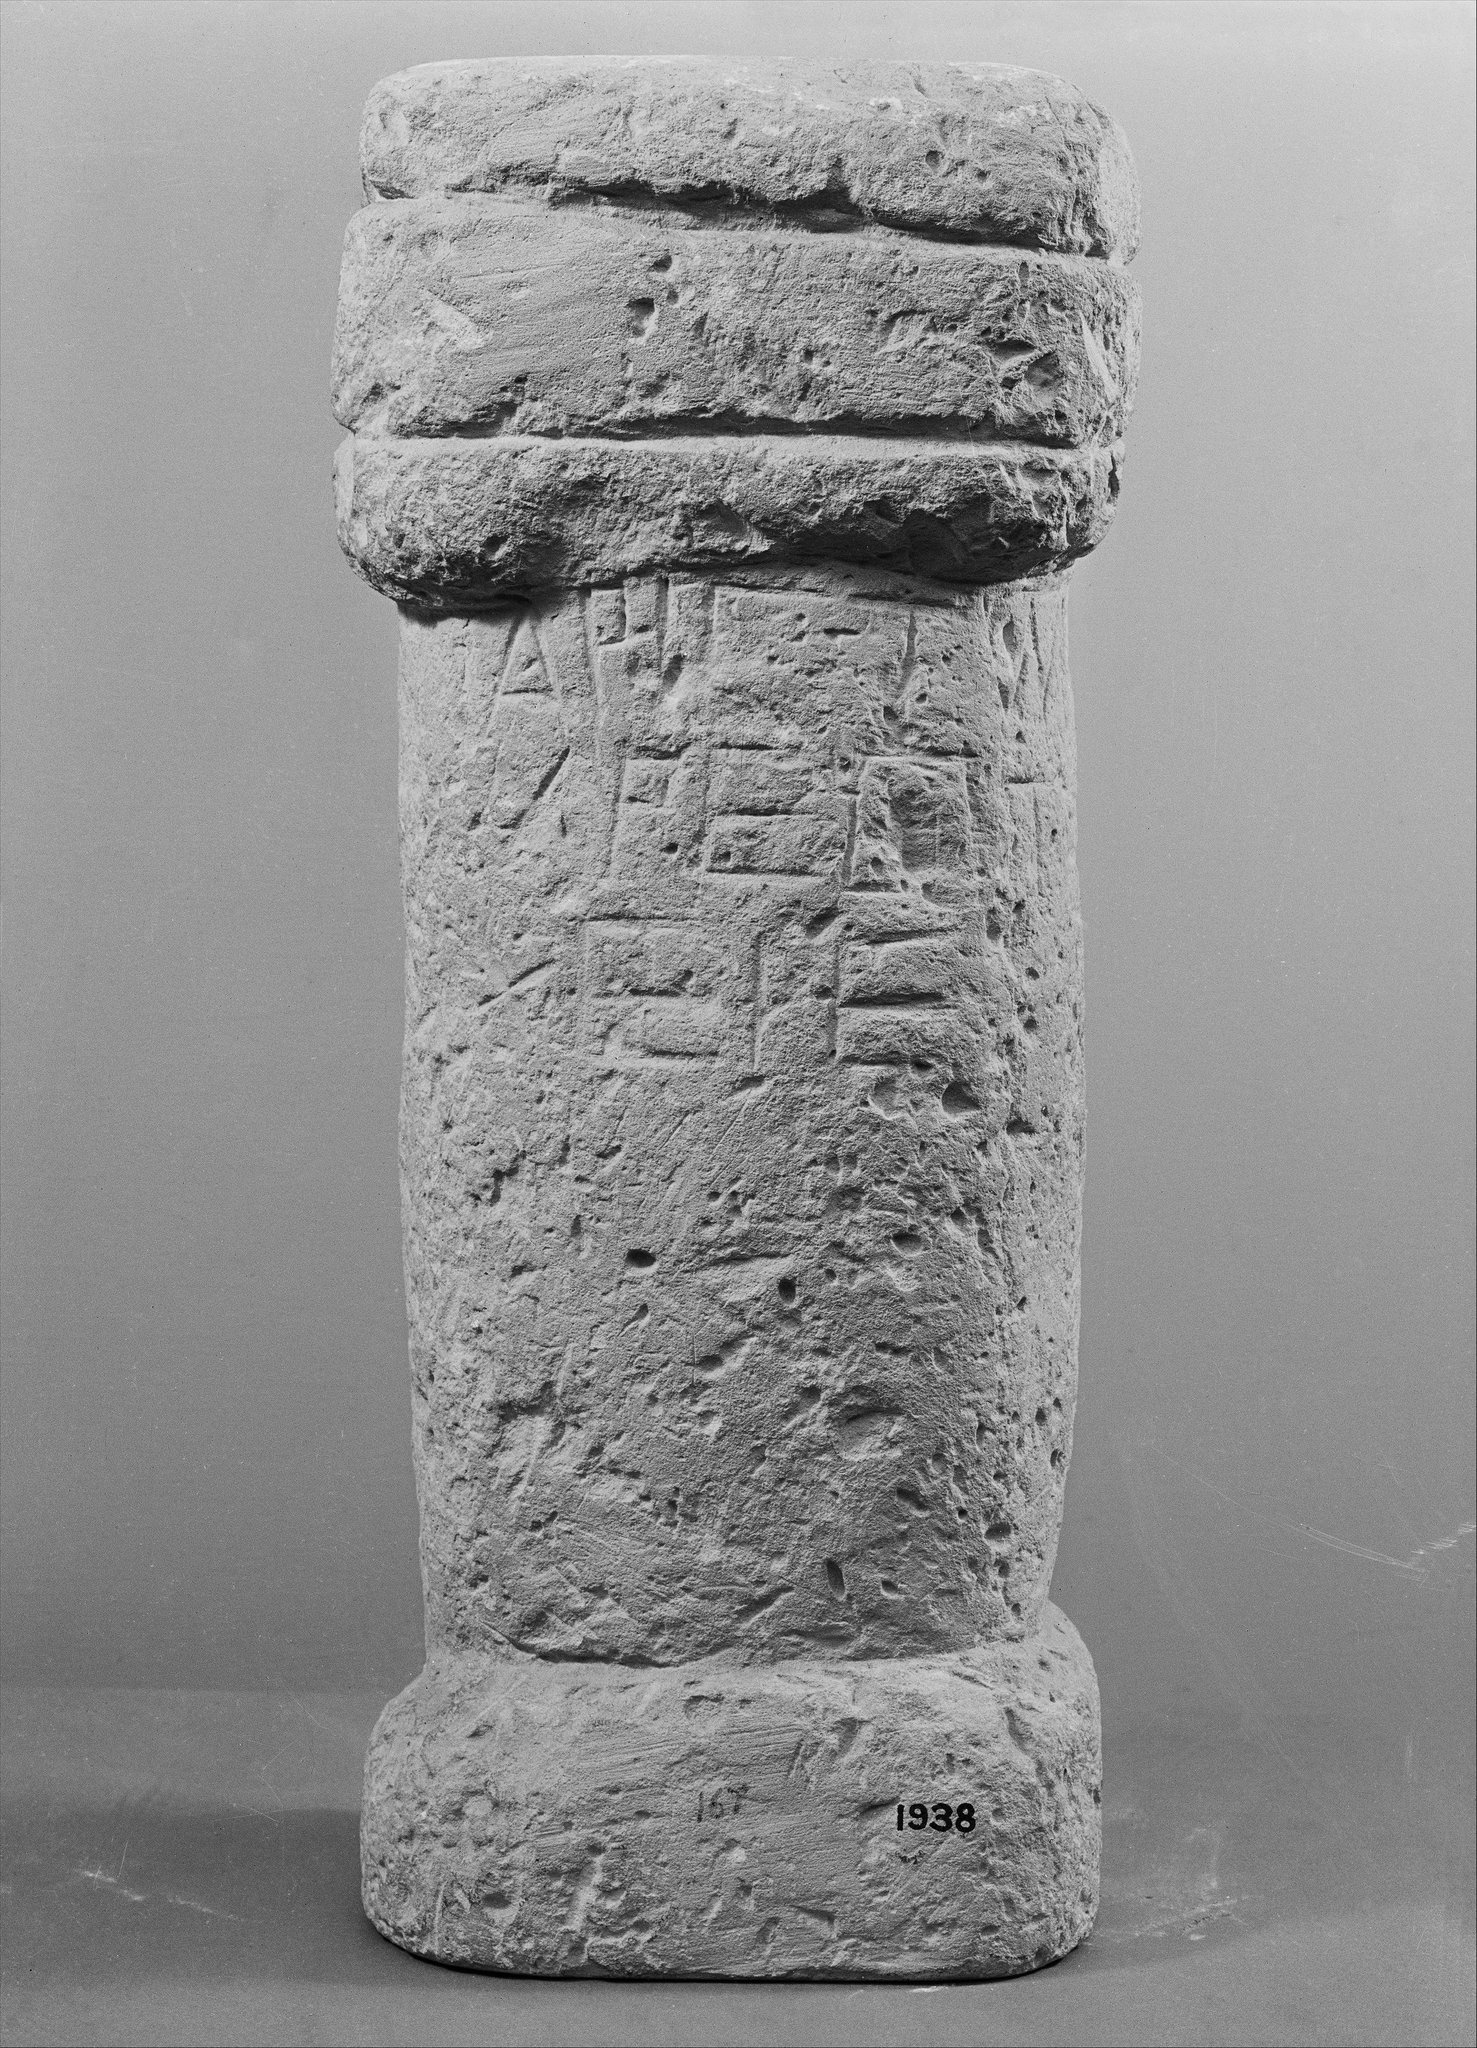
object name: cippus of ariston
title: Limestone cippus of Ariston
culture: roman, cypriot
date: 101-300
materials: limestone